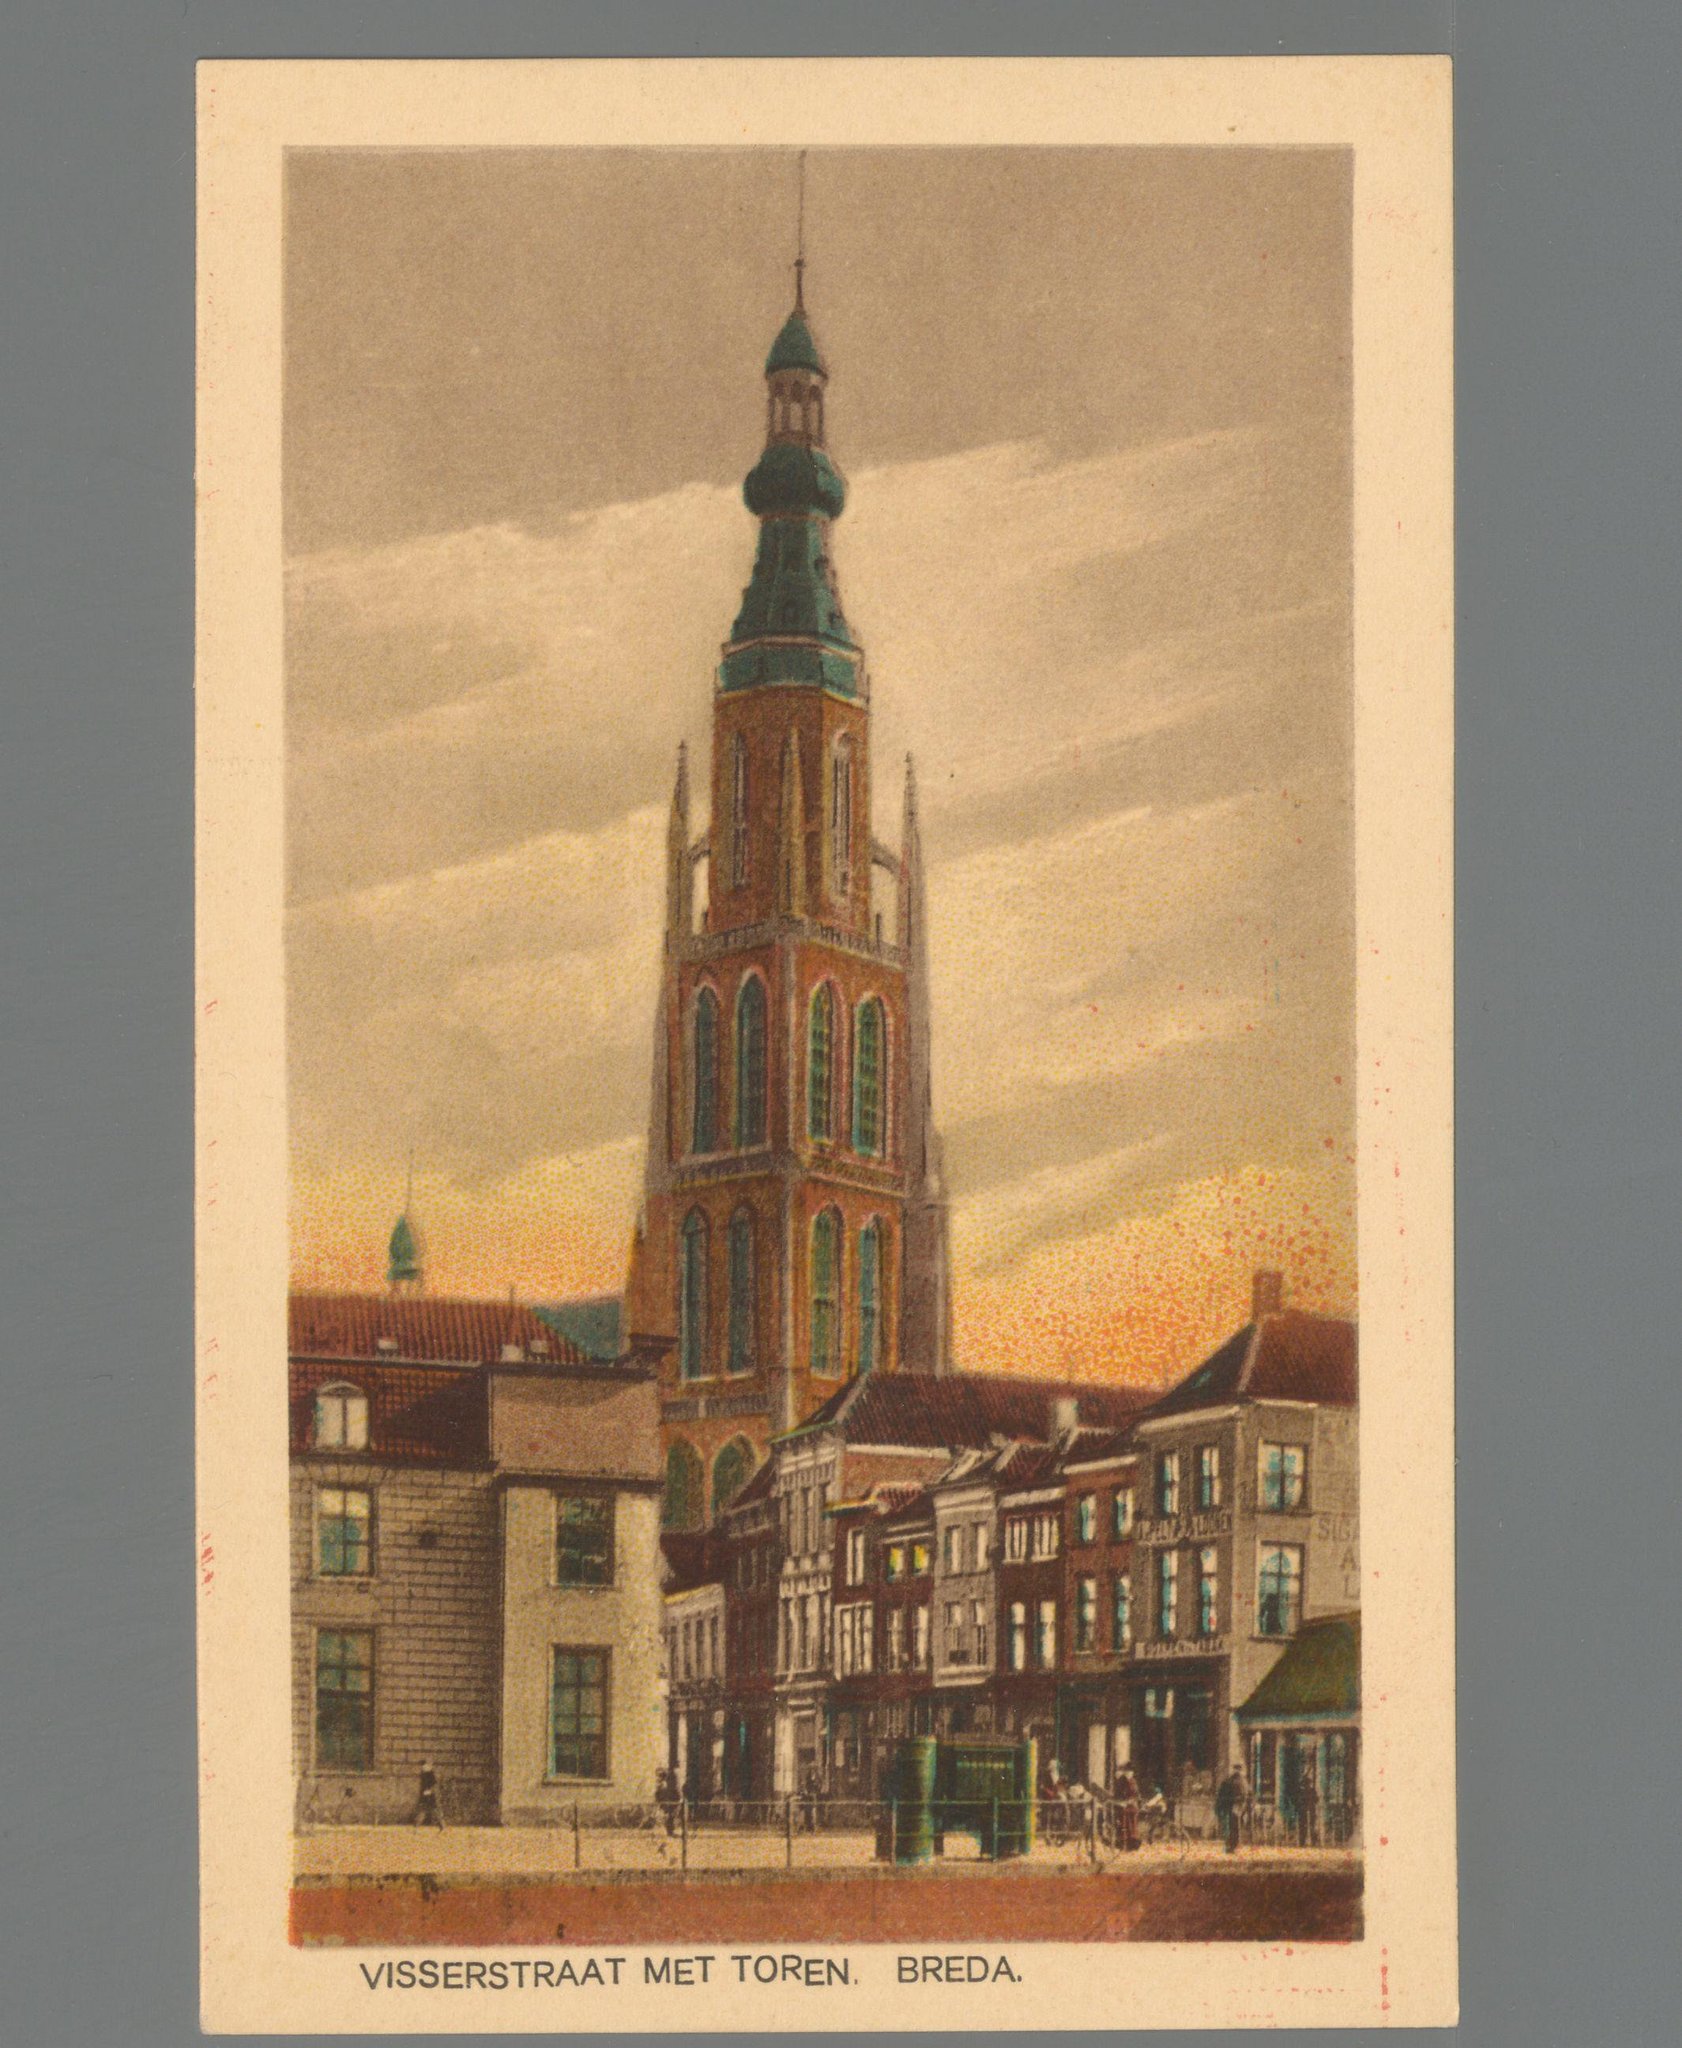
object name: photomechanical print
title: Visserstraat met toren. Breda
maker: Anonymous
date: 1913-1945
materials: cardboard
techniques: photograph, lithograph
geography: breda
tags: city-view, and landscape with man-made constructions, church (exterior)